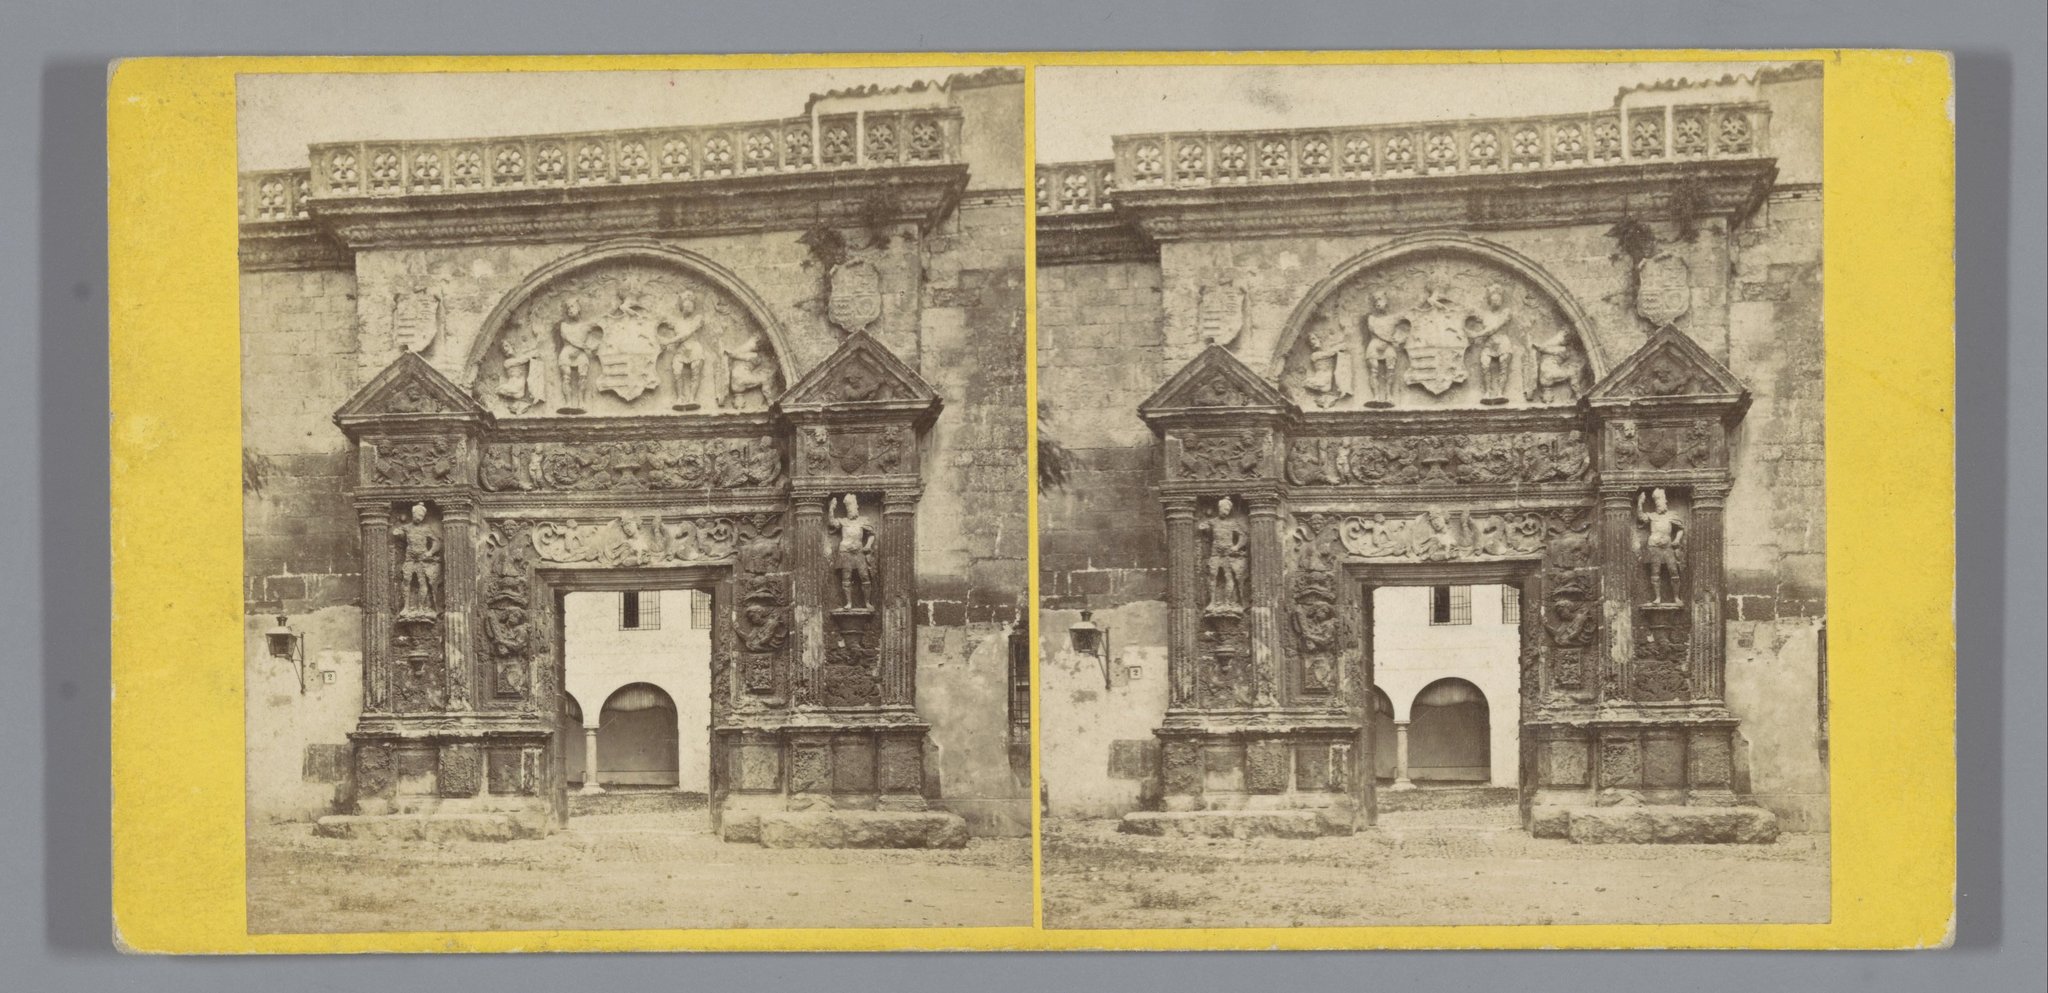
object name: stereograph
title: Cordova - Door of Cathedral and College.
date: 1860-1880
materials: cardboard, photographic support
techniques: albumen print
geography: córdoba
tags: gate, entrance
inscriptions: name: ‘Frank M. Good's Spain’, number: ‘No. 297’